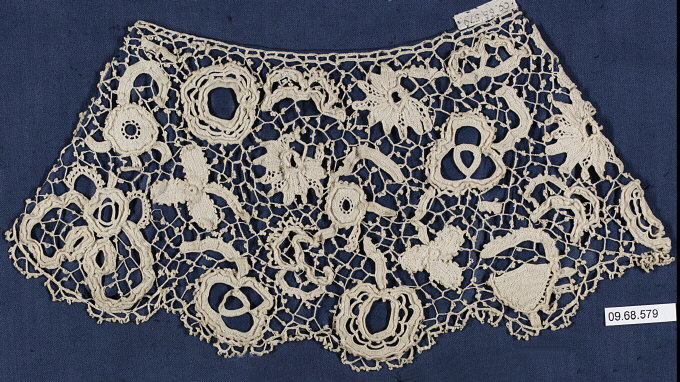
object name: cuff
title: Cuff (one of a pair)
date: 1801-1900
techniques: crochet